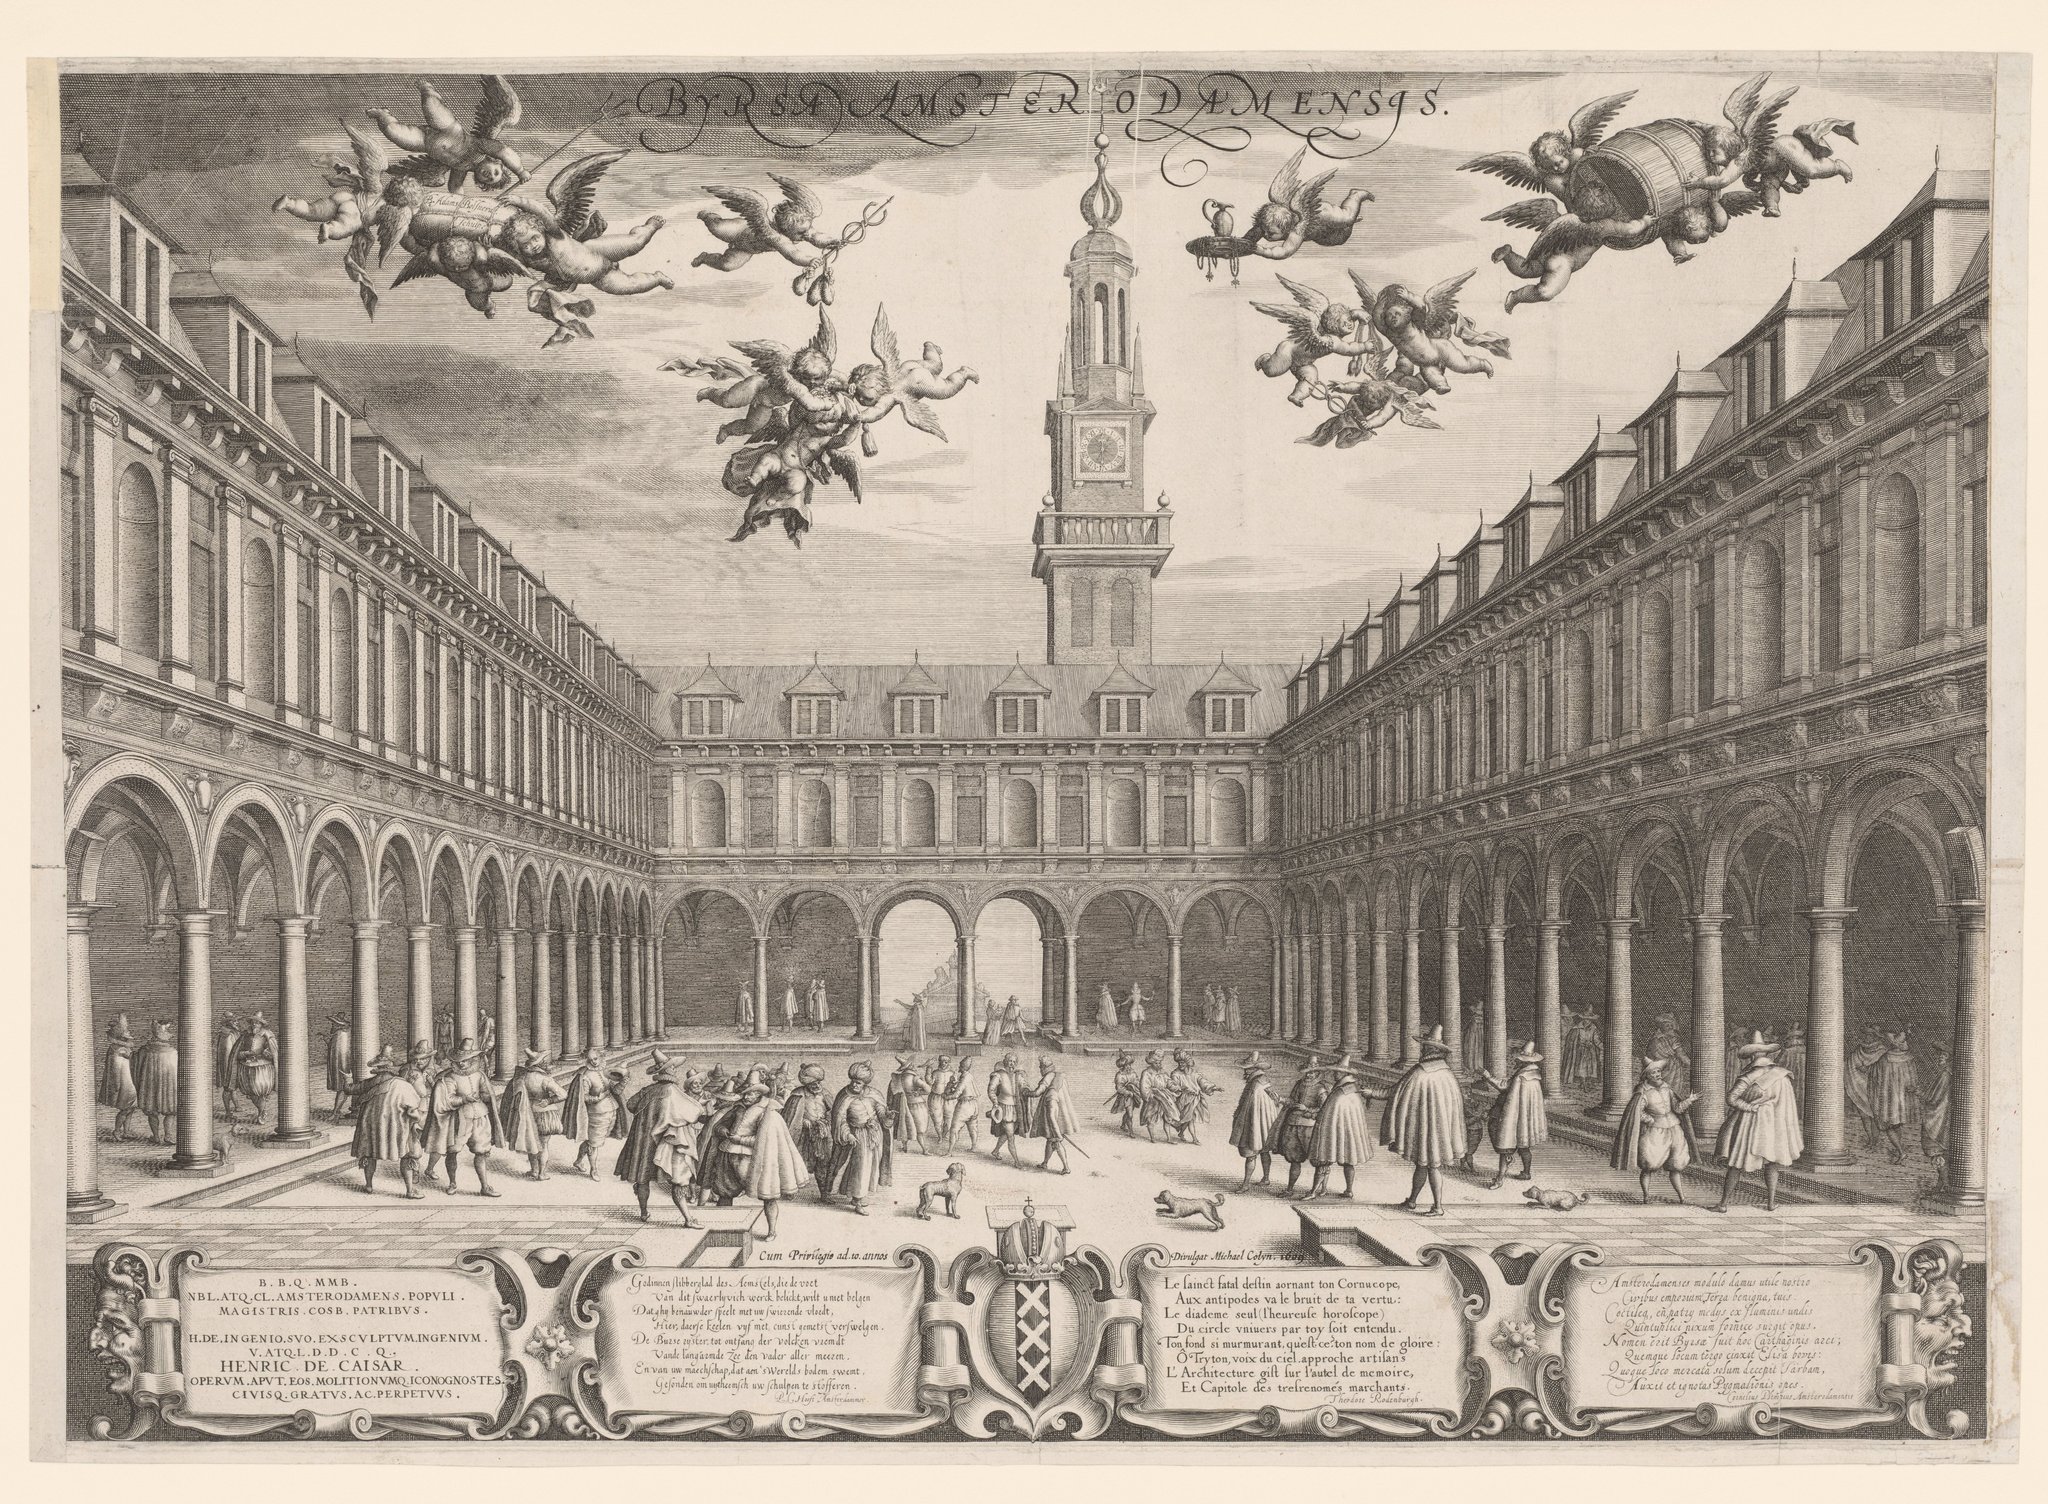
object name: print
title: Byrsa Amsterodamensis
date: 1609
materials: paper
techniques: engraving, etching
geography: northern netherlands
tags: stock exchange, stock-market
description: Binnenplaats van de beurs van Hendrik de Keyser in Amsterdam in 1609. Met kooplieden uit binnen- en buitenland. In de lucht engelen met attributen van de handel en welvaart. Middenonder het wapen van Amsterdam en vier cartouches met een Latijnse tekst en gedichten van P.C. Hooft, T. Rodenburgh en C. Plemp in respectievelijk Nederlands, Frans en Latijn.